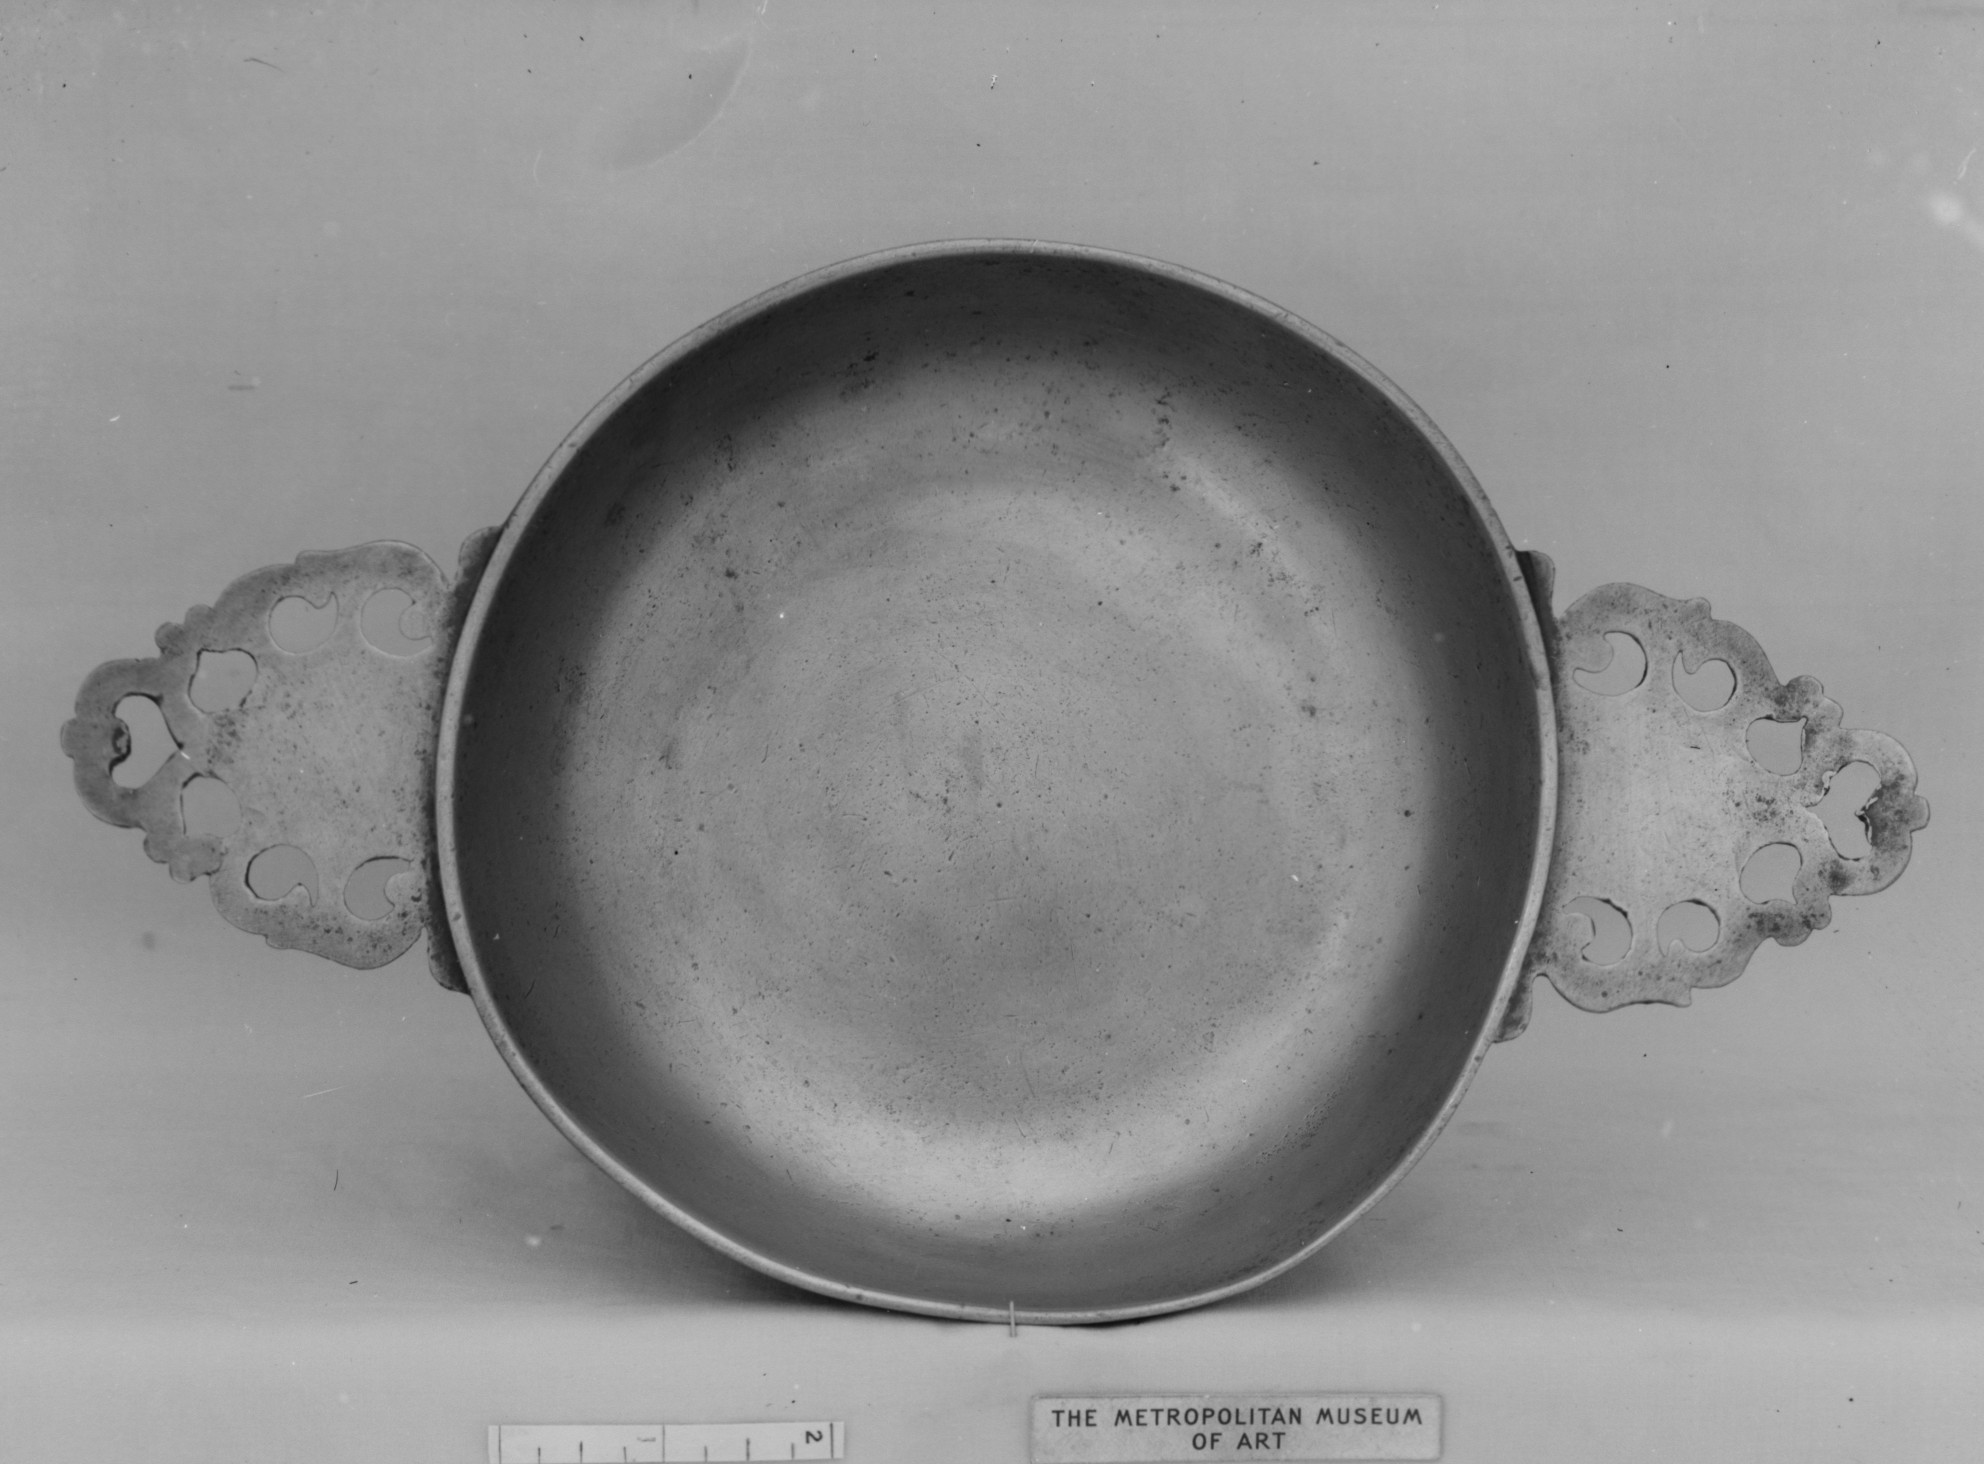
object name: porringer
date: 1667-1800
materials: pewter